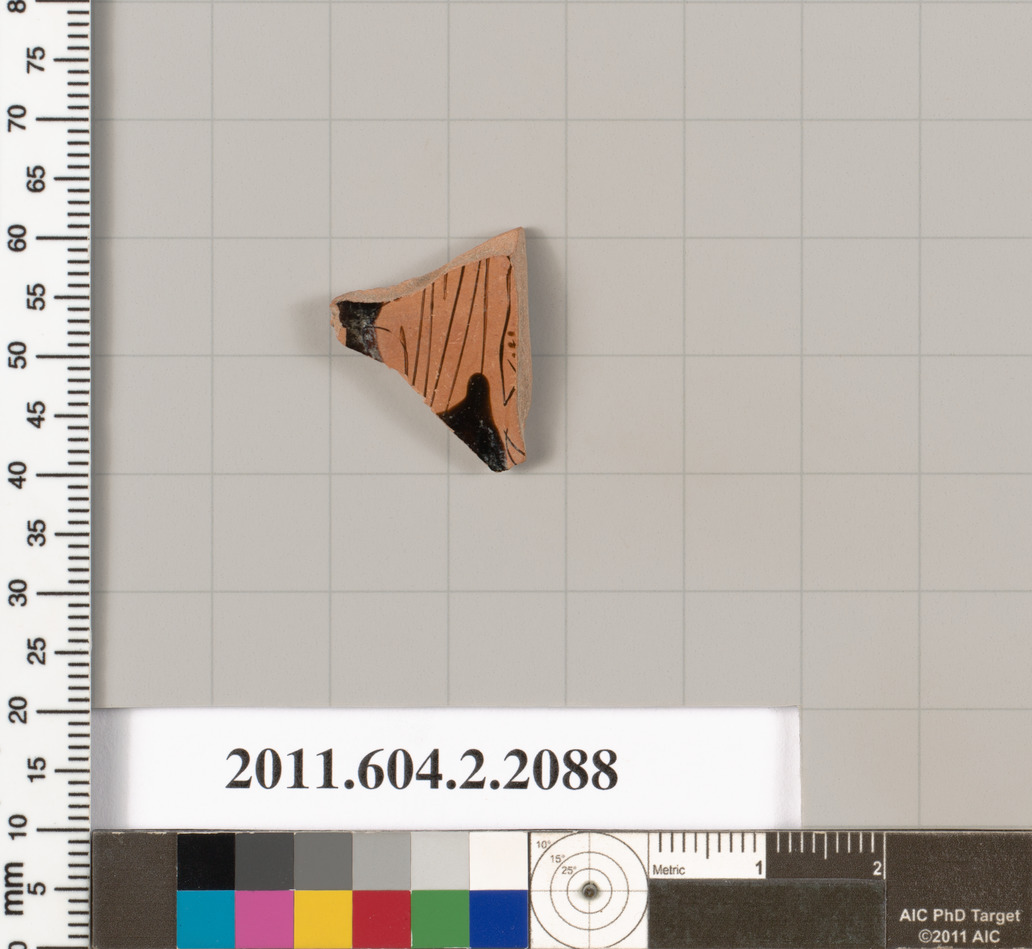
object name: pot fragment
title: Terracotta fragment of a pot; glazed on the inside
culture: greek, attic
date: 460-440 BCE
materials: terracotta